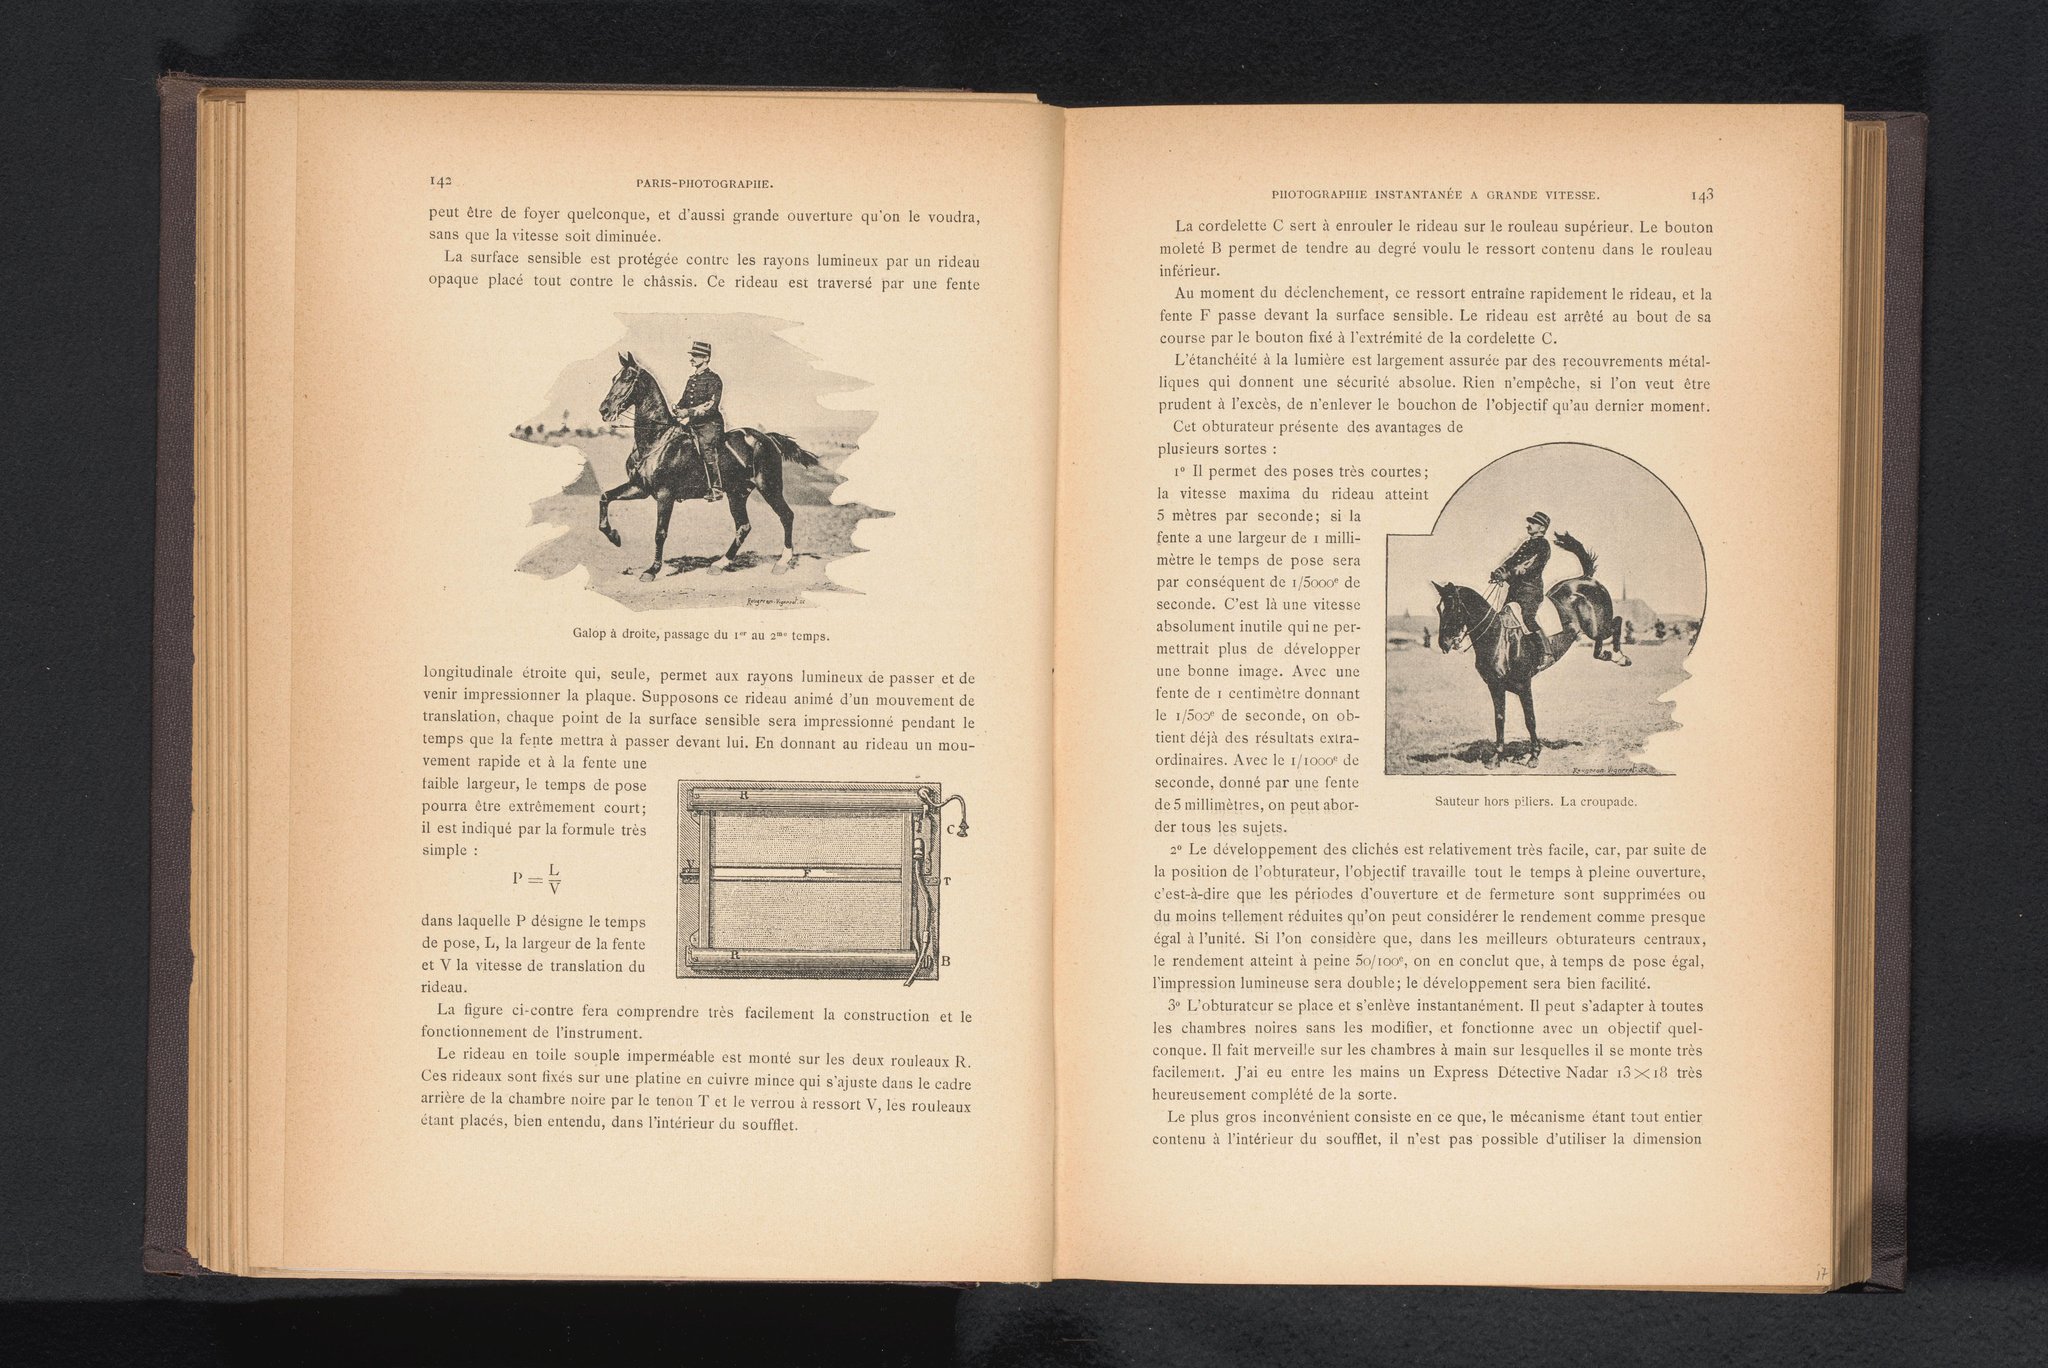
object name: photomechanical print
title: Man op een paard in galop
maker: Anonymous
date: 1883-1893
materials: paper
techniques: autotype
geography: france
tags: riding a horse, ass, or mule; rider, horseman, horse